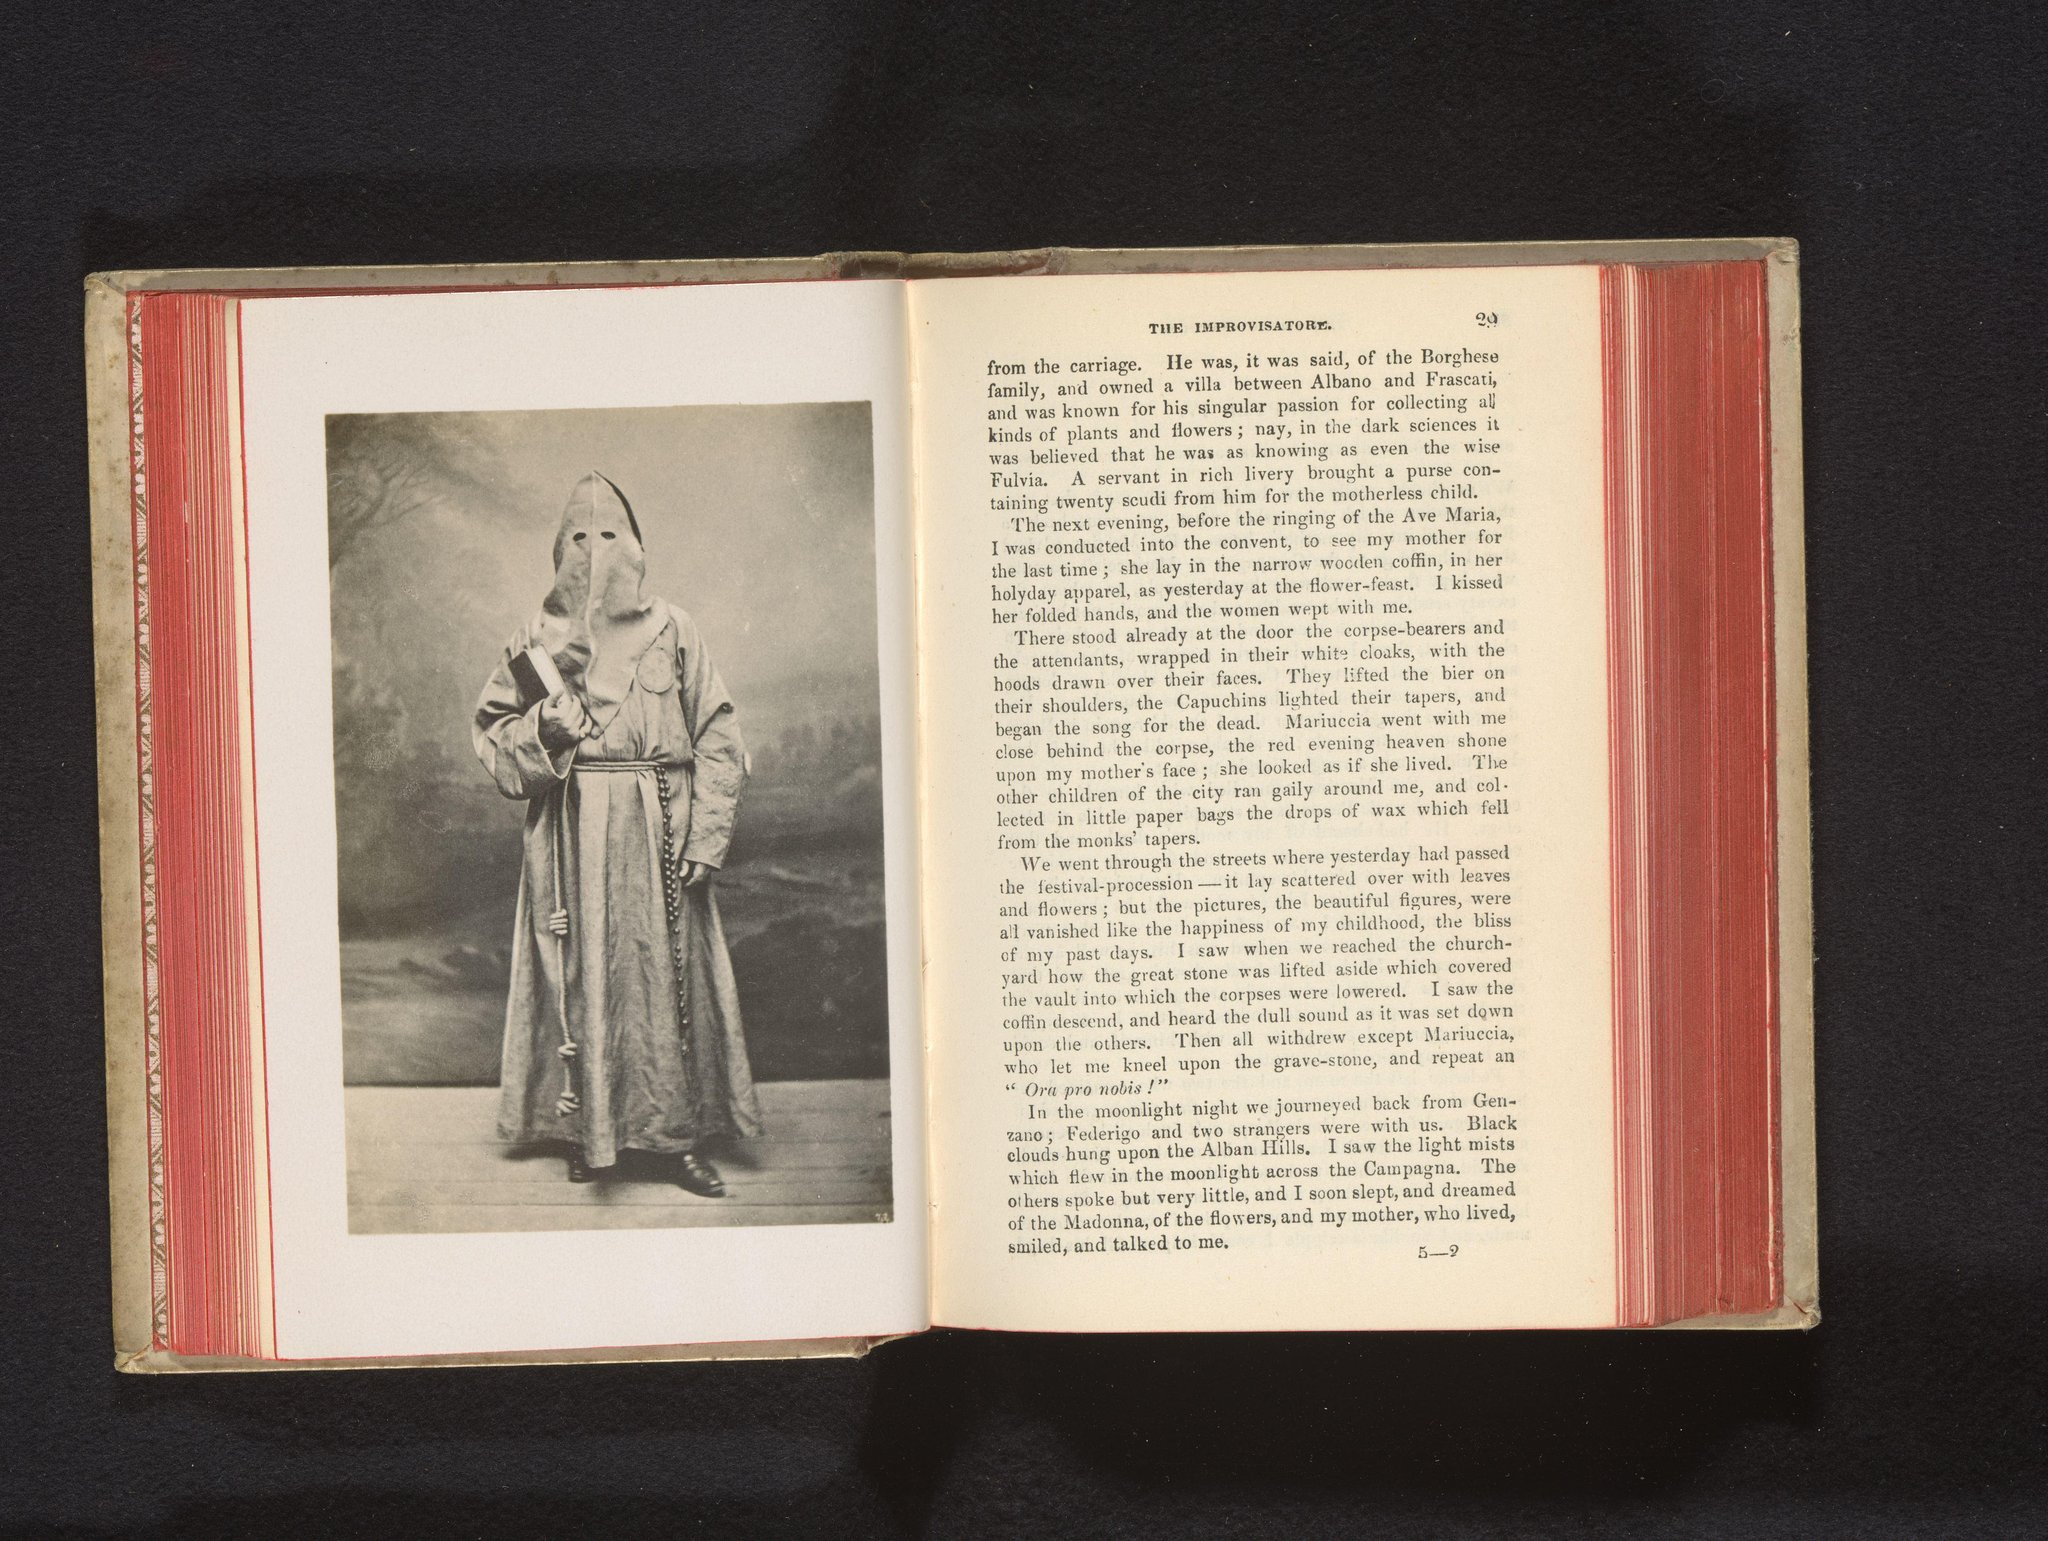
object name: photograph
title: Franciscaner monnik met een kap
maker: Anonymous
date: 1870-1880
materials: photographic support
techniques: gelatin silver print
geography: rome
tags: head-gear: hood, monk(s), friar(s), monastic orders, monastic life: franciscans